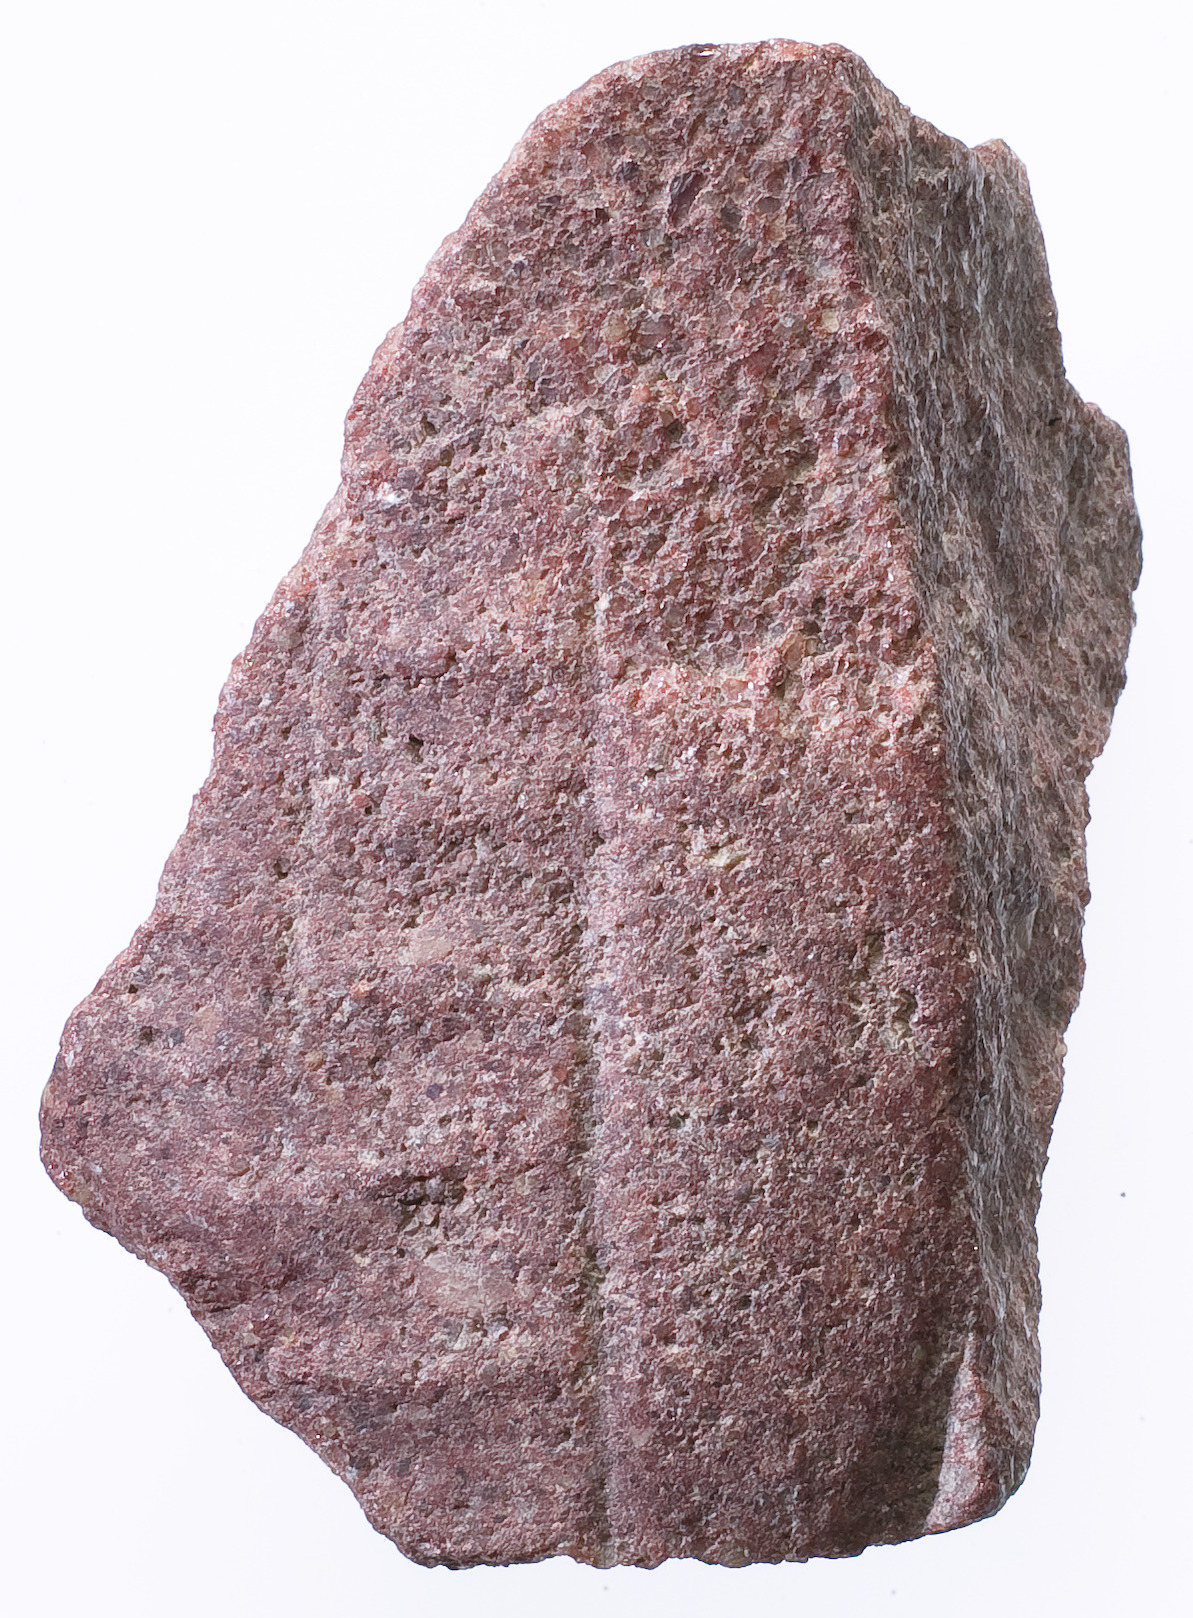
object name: tie or streamer ribbing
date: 1353-1336 BCE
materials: quartzite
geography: egypt